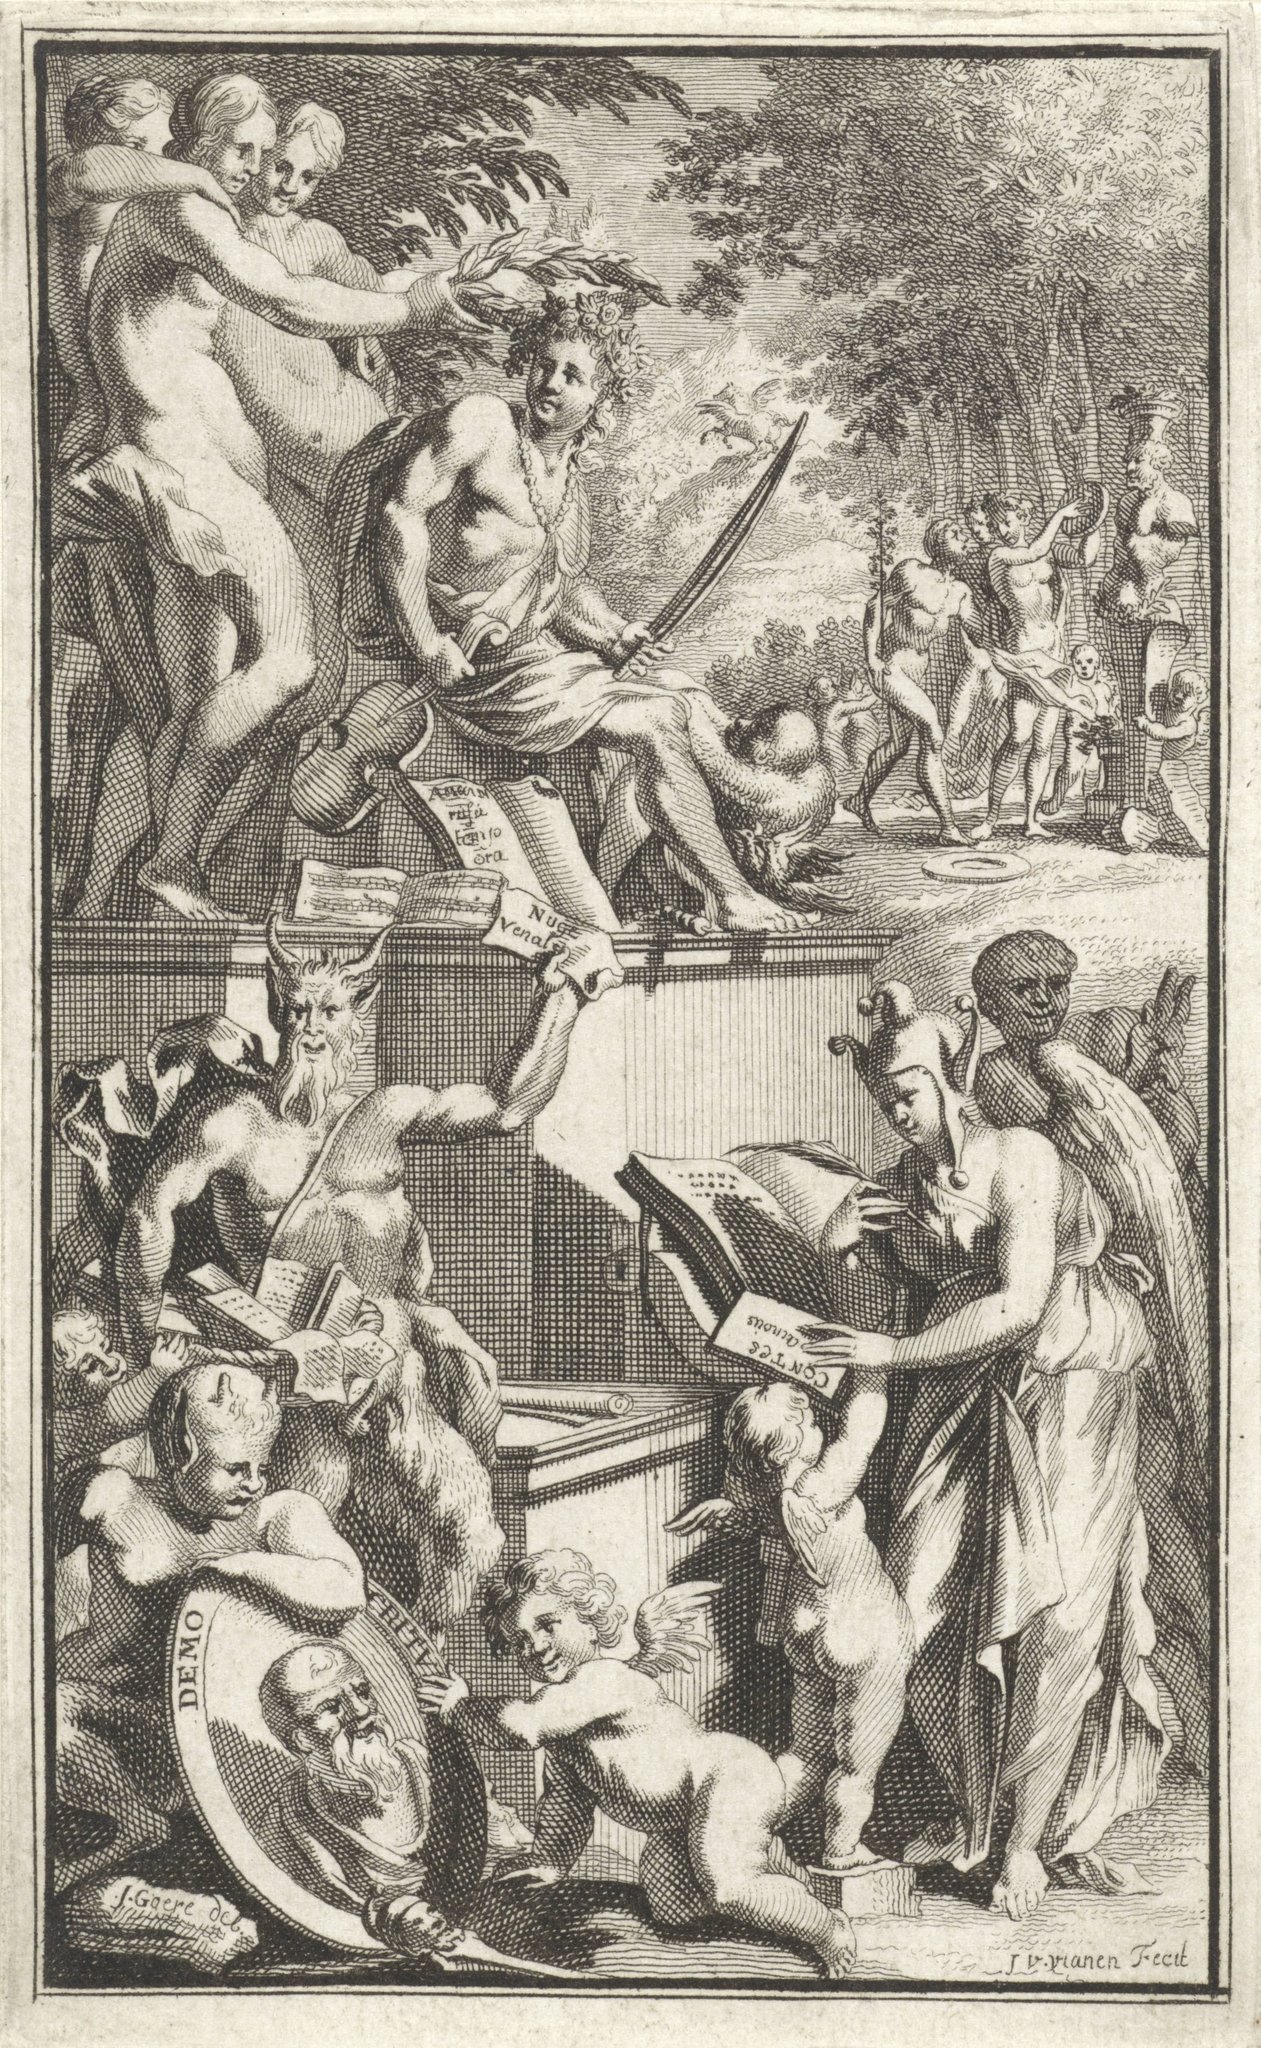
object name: print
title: Titelpagina voor een onbekend boek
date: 1639-1670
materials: paper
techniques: engraving, etching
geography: northern netherlands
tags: (story of) apollo (phoebus), priapus-herm, graces (charites), generally three in number; 'gratie' (ripa), satyr(s) (in general), (story of) democritus, the philosopher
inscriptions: collector's mark: Lugt 2228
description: De drie gratiën kronen Apollo, zittend op een sokkel, met een lauwerkrans. Op de voorgrond een gevleugelde figuur met een narrenkap en een putto. Links een putto en saters bij een portret van Democrtius. Op de achtergrond dansen figuren rond een herm, waarschijnlijk voorstellende Priapus.